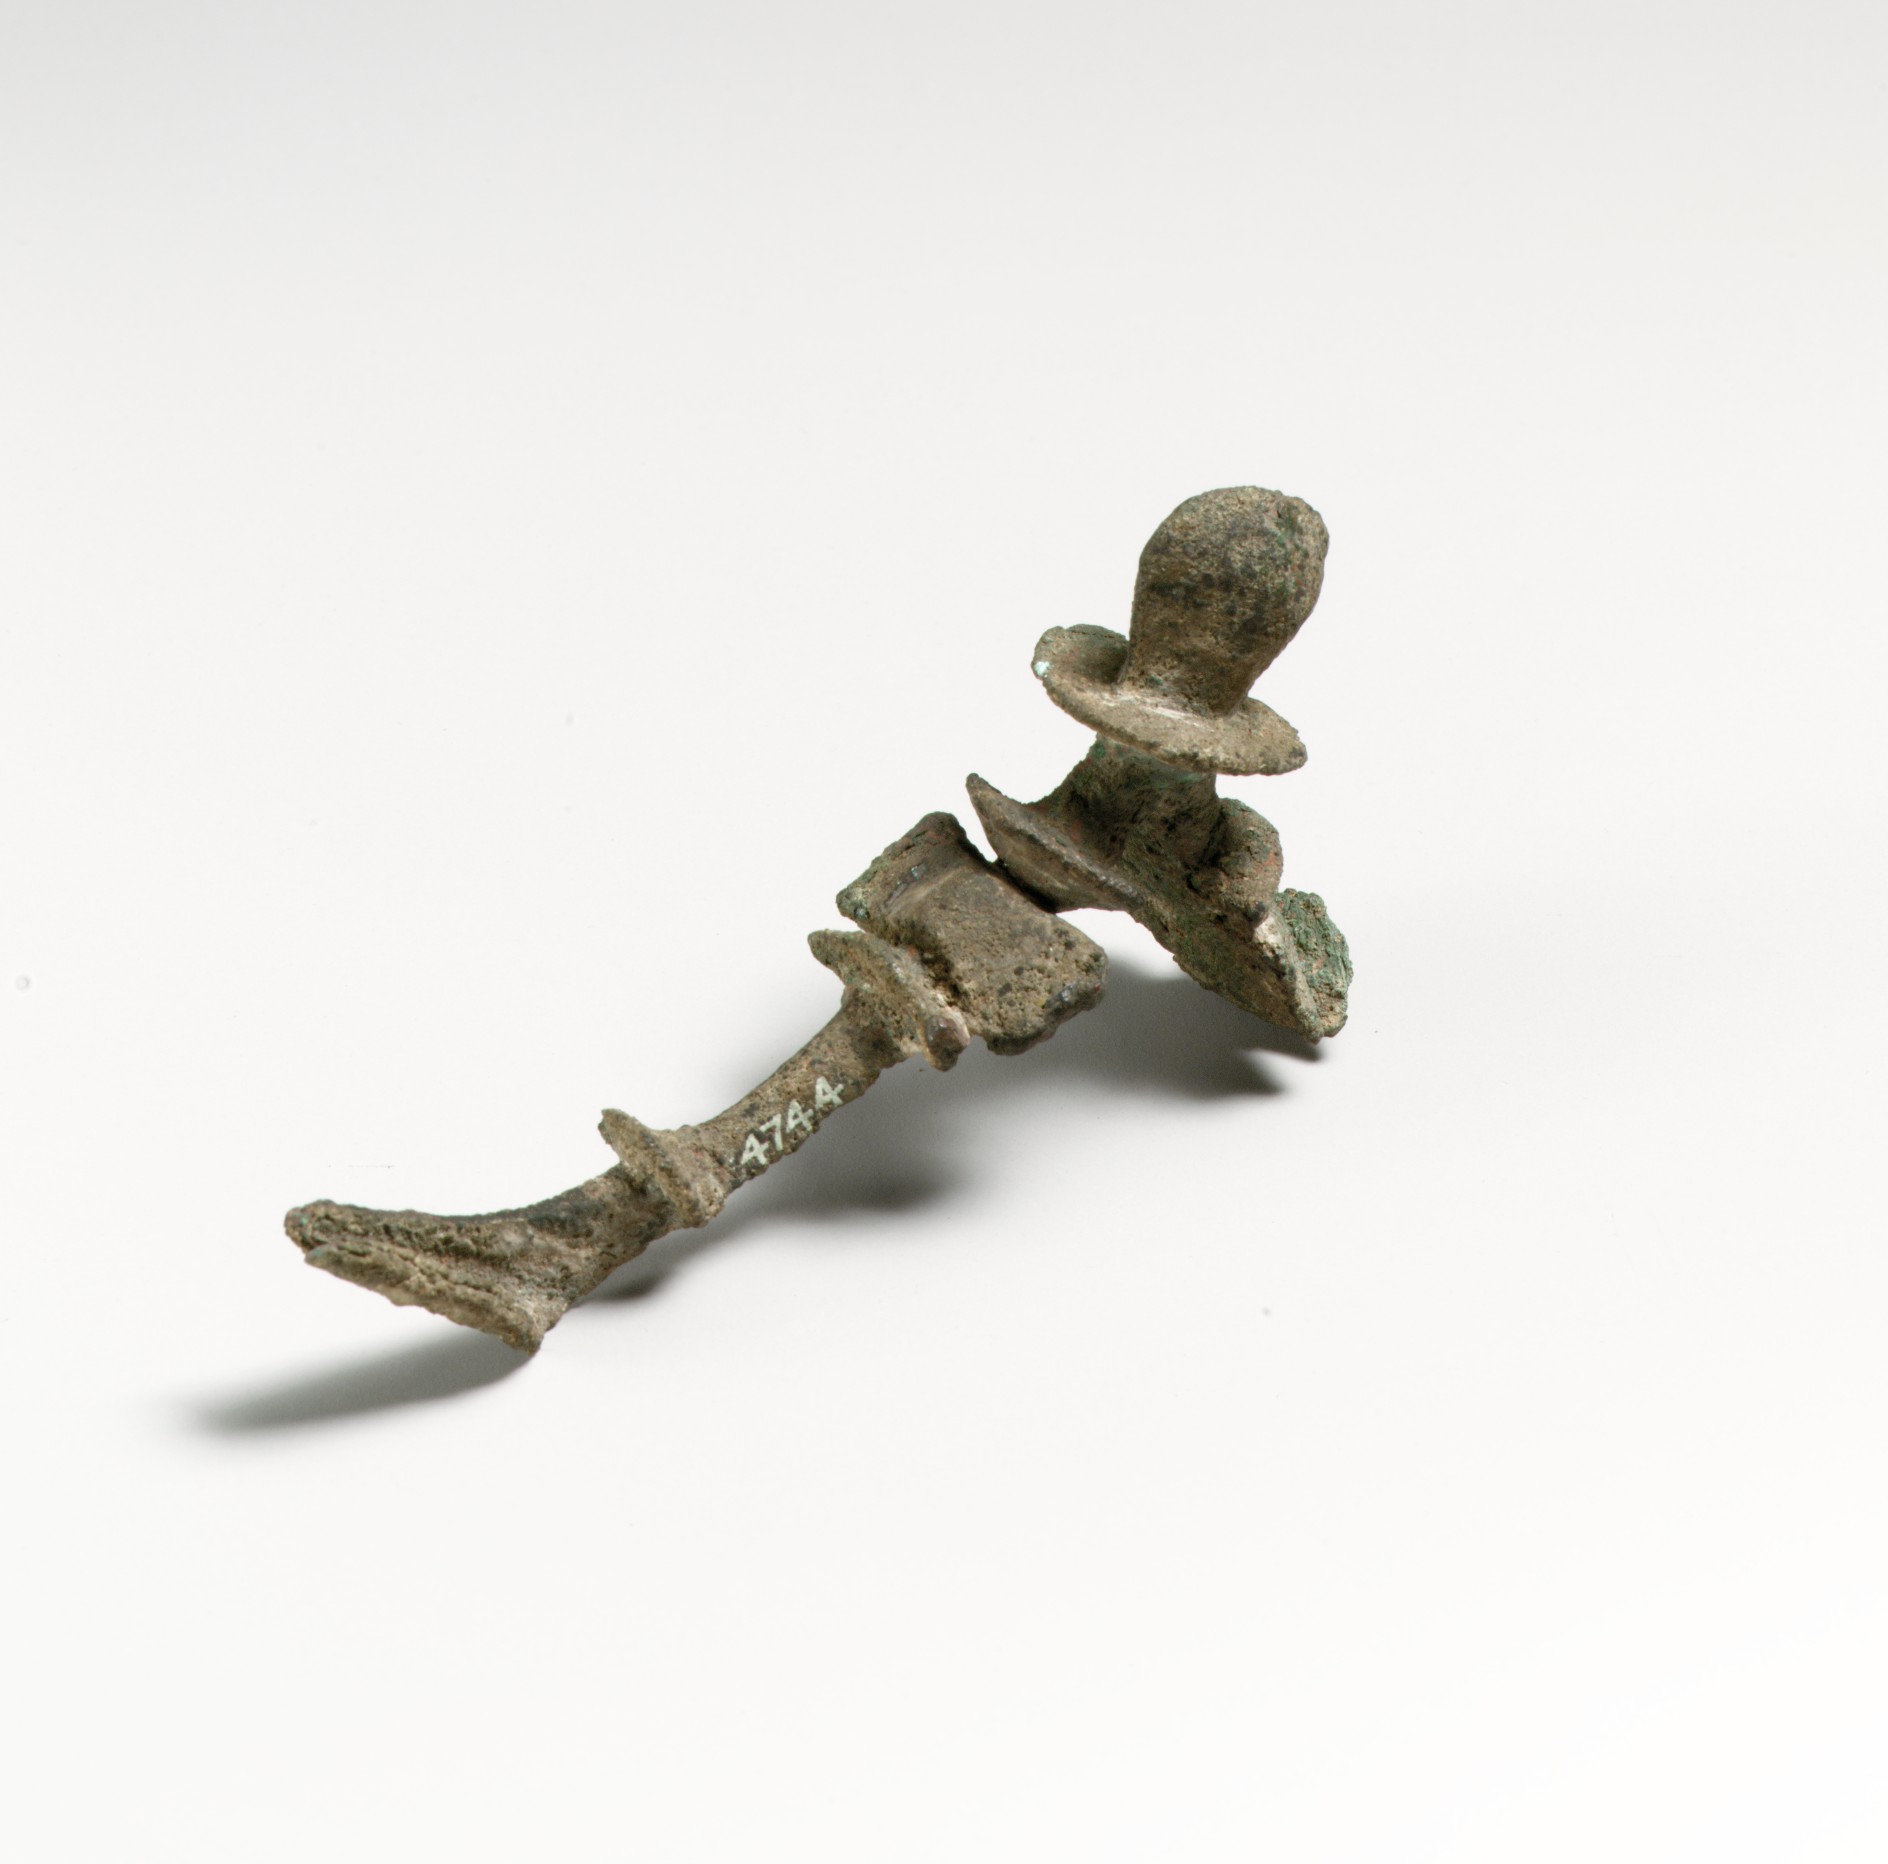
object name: fibula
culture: greek, cypriot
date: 7000-30 BCE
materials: bronze